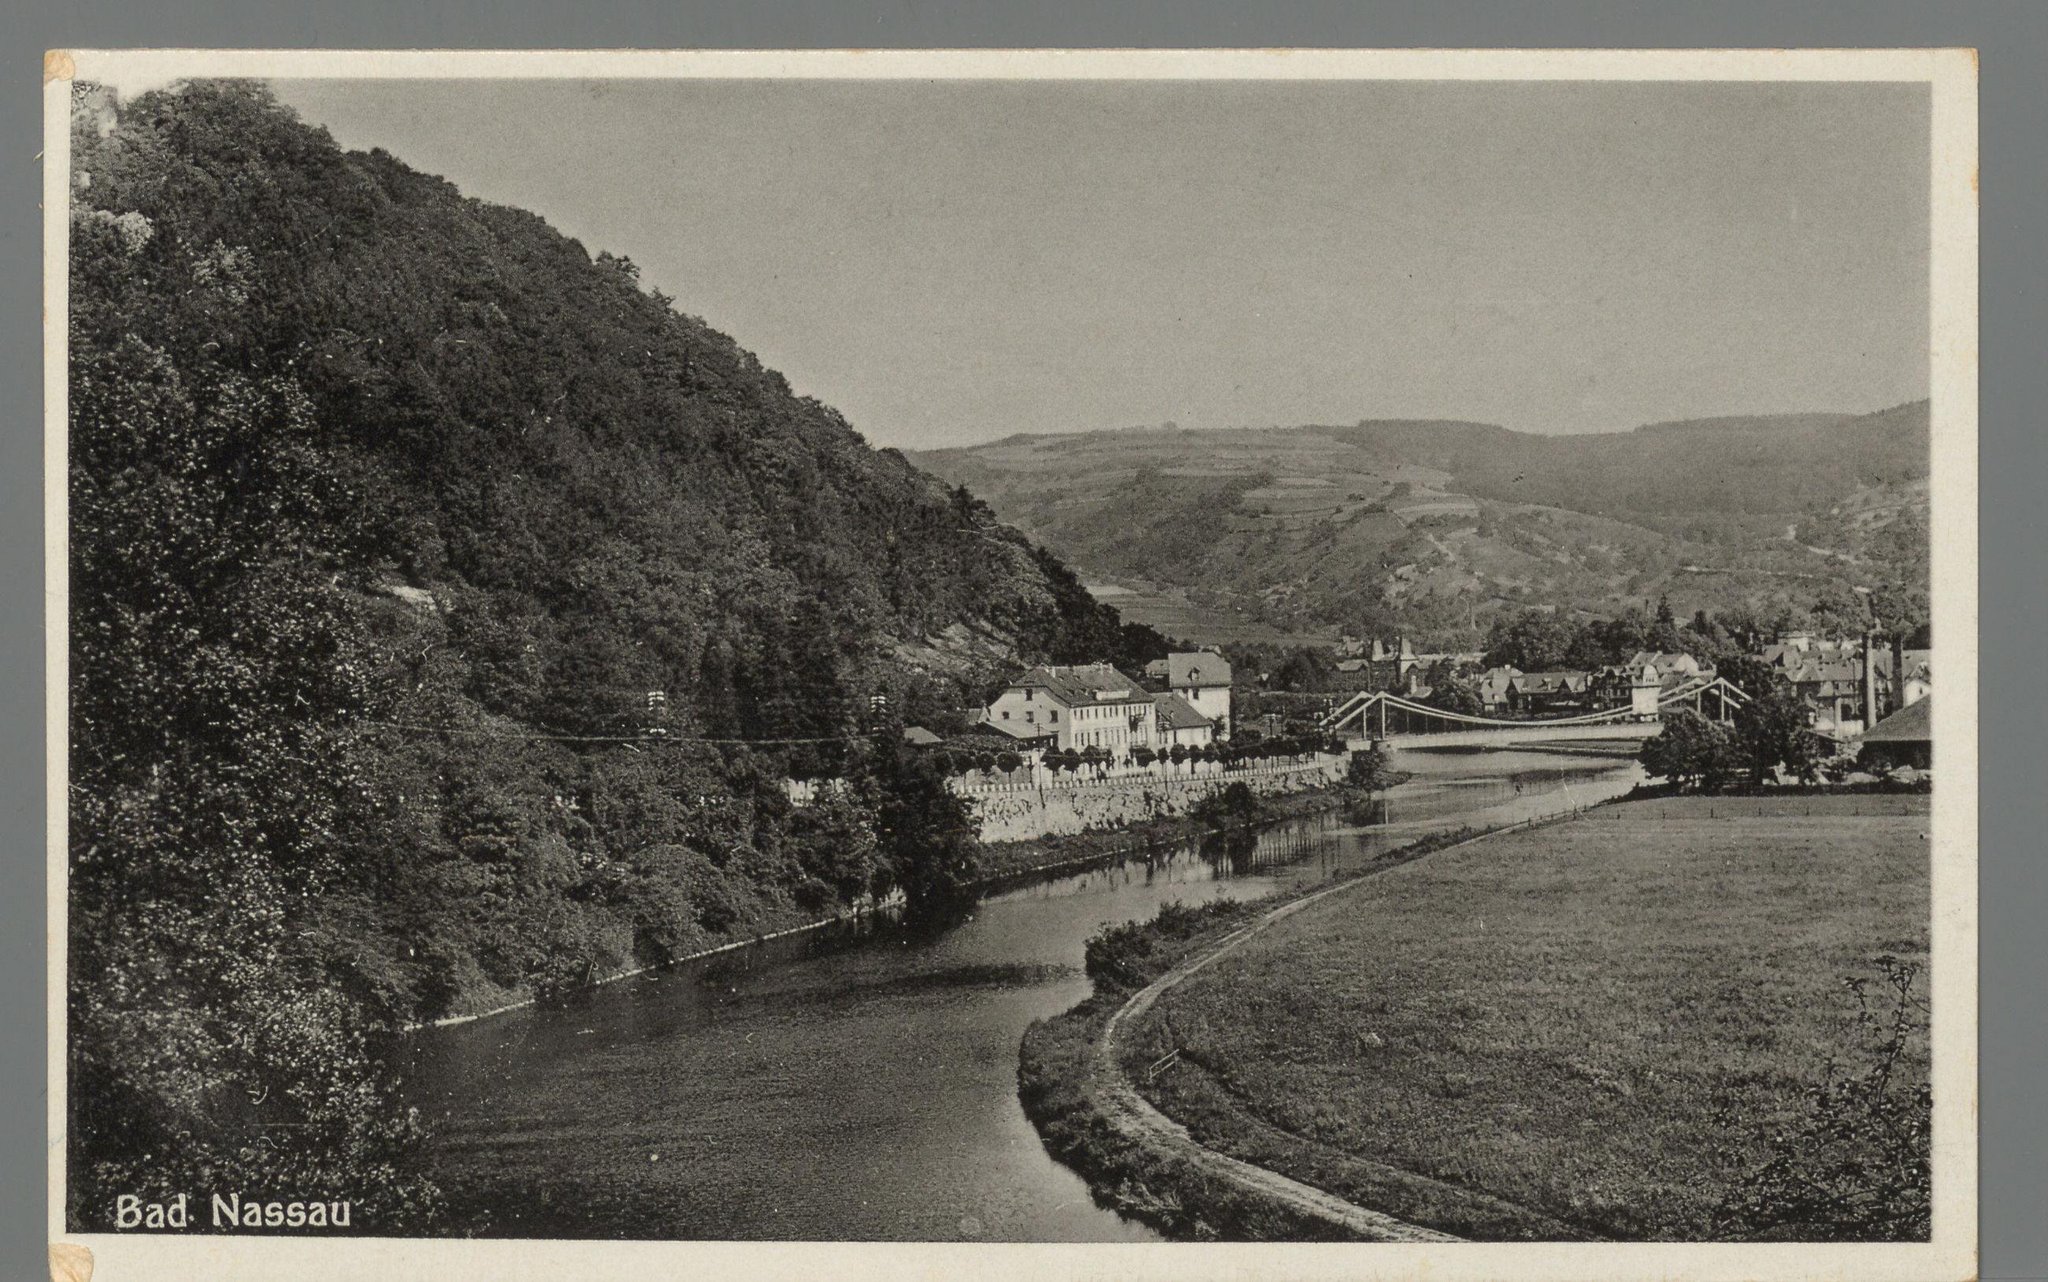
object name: ansichtkaart, prentbriefkaart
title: Bad Nassau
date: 1905-1930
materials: cardboard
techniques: photograph, writing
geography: nassau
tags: city-view, and landscape with man-made constructions, canals, waters (in city), bridge in city across river, canal, etc.